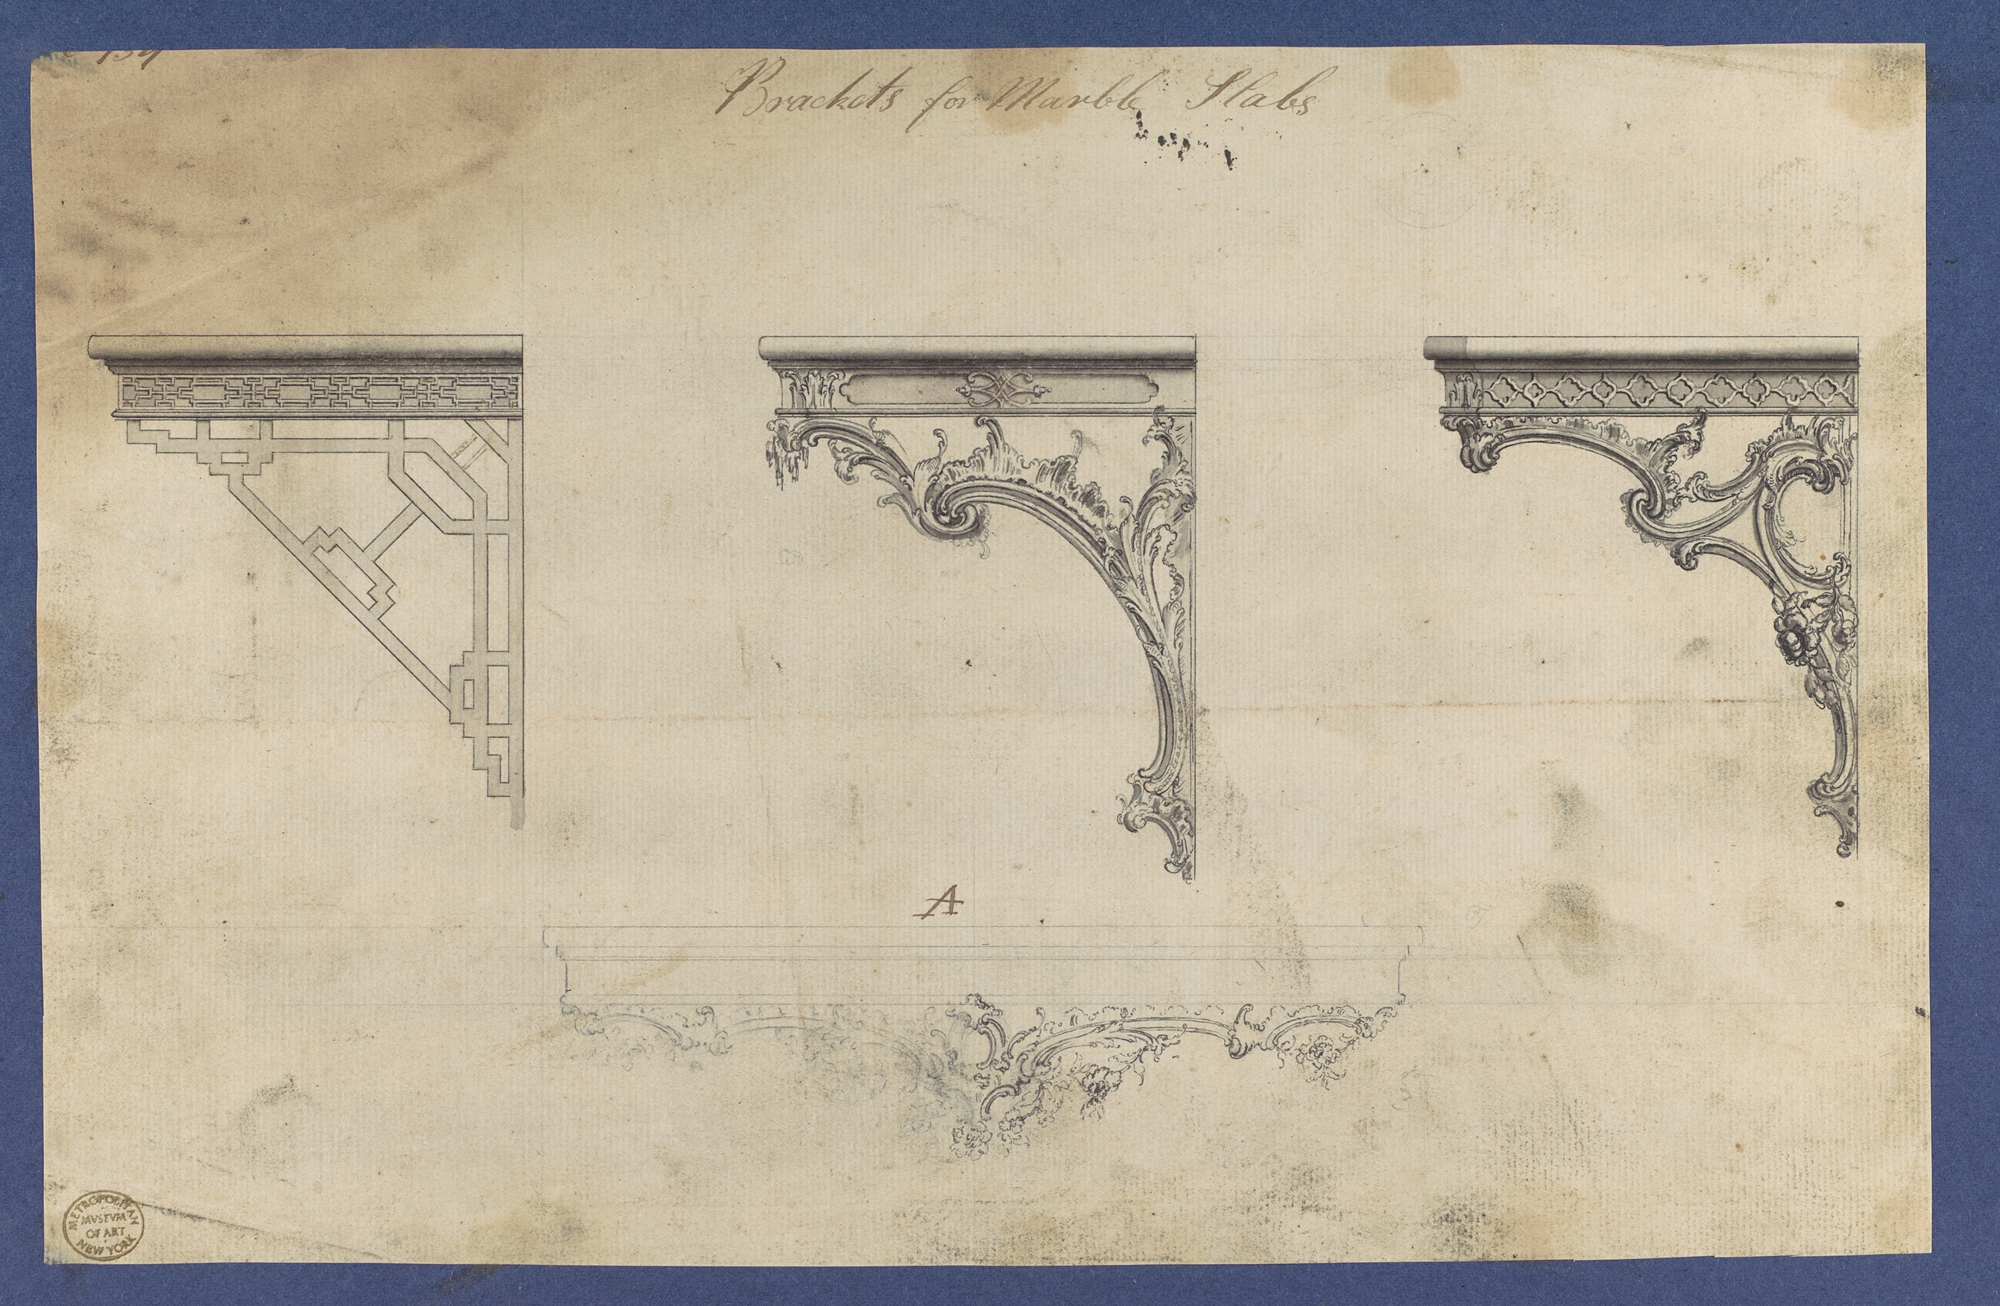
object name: drawing ornament architecture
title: Brackets for Marble Slabs, in Chippendale Drawings, Vol. I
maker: thomas chippendale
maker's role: artist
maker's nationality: british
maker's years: 1718-1779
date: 1754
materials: ink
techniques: wash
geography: london